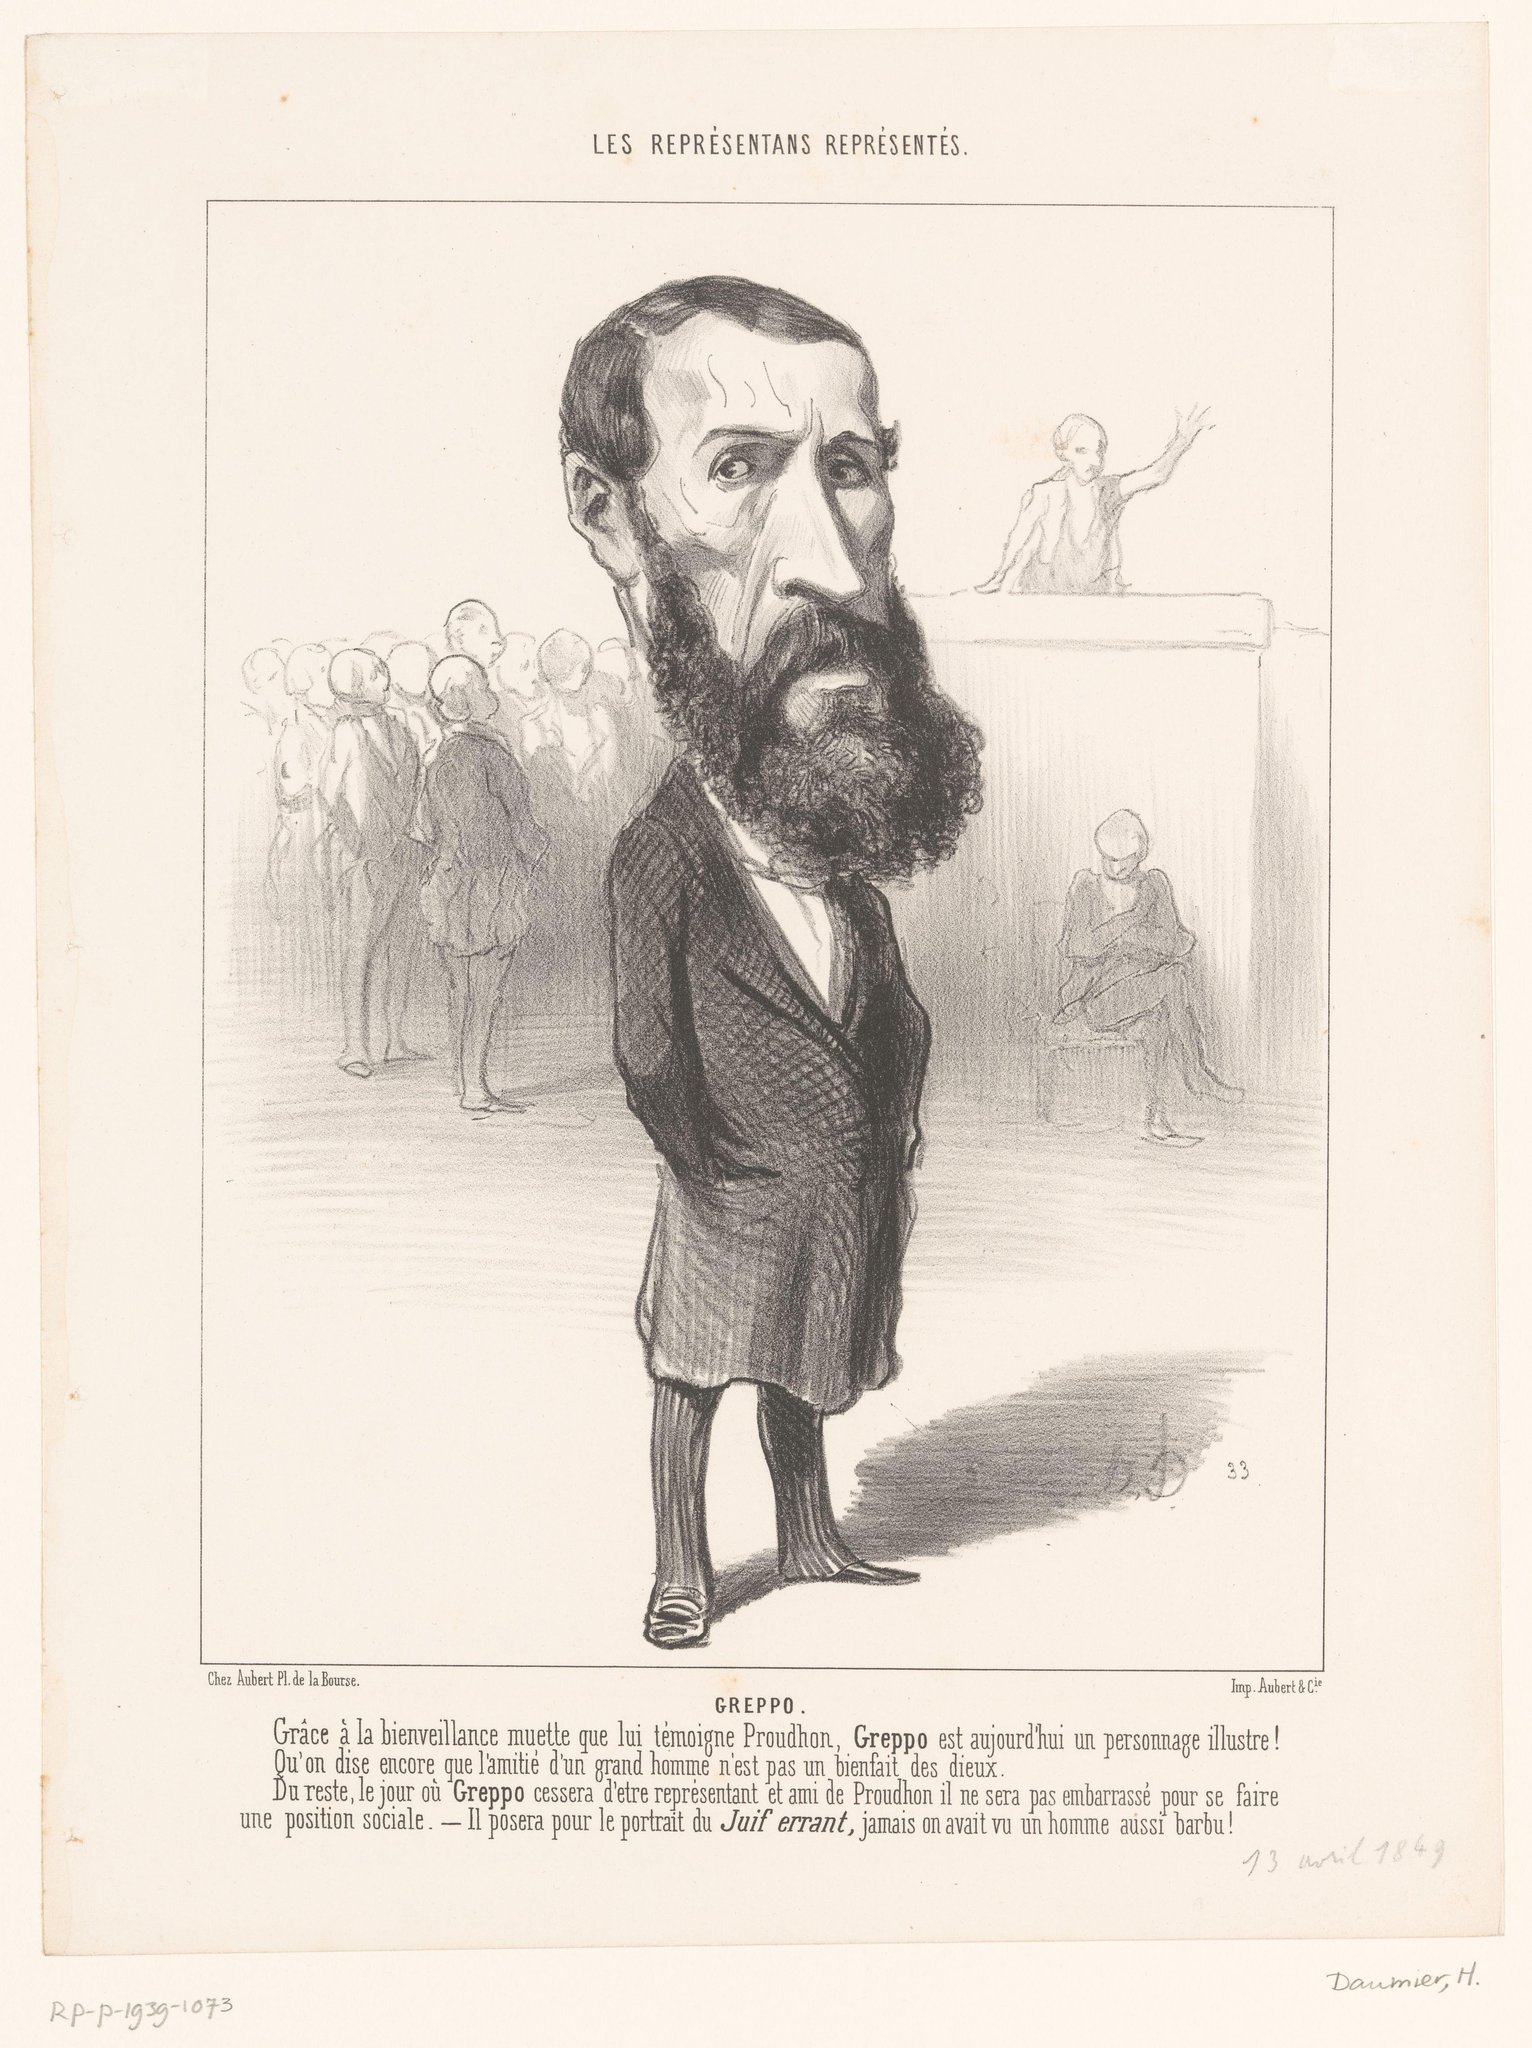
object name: cartoon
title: Greppo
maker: honoré daumier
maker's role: draughtsman, painter, print maker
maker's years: 1808-1879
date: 1849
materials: paper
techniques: lithograph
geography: paris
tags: caricatures (human types), historical persons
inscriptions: collector's mark: Lugt 2760, collector's mark: Lugt 2166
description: Prent gebruikt voor: Le Charivari, 13 april 1849.